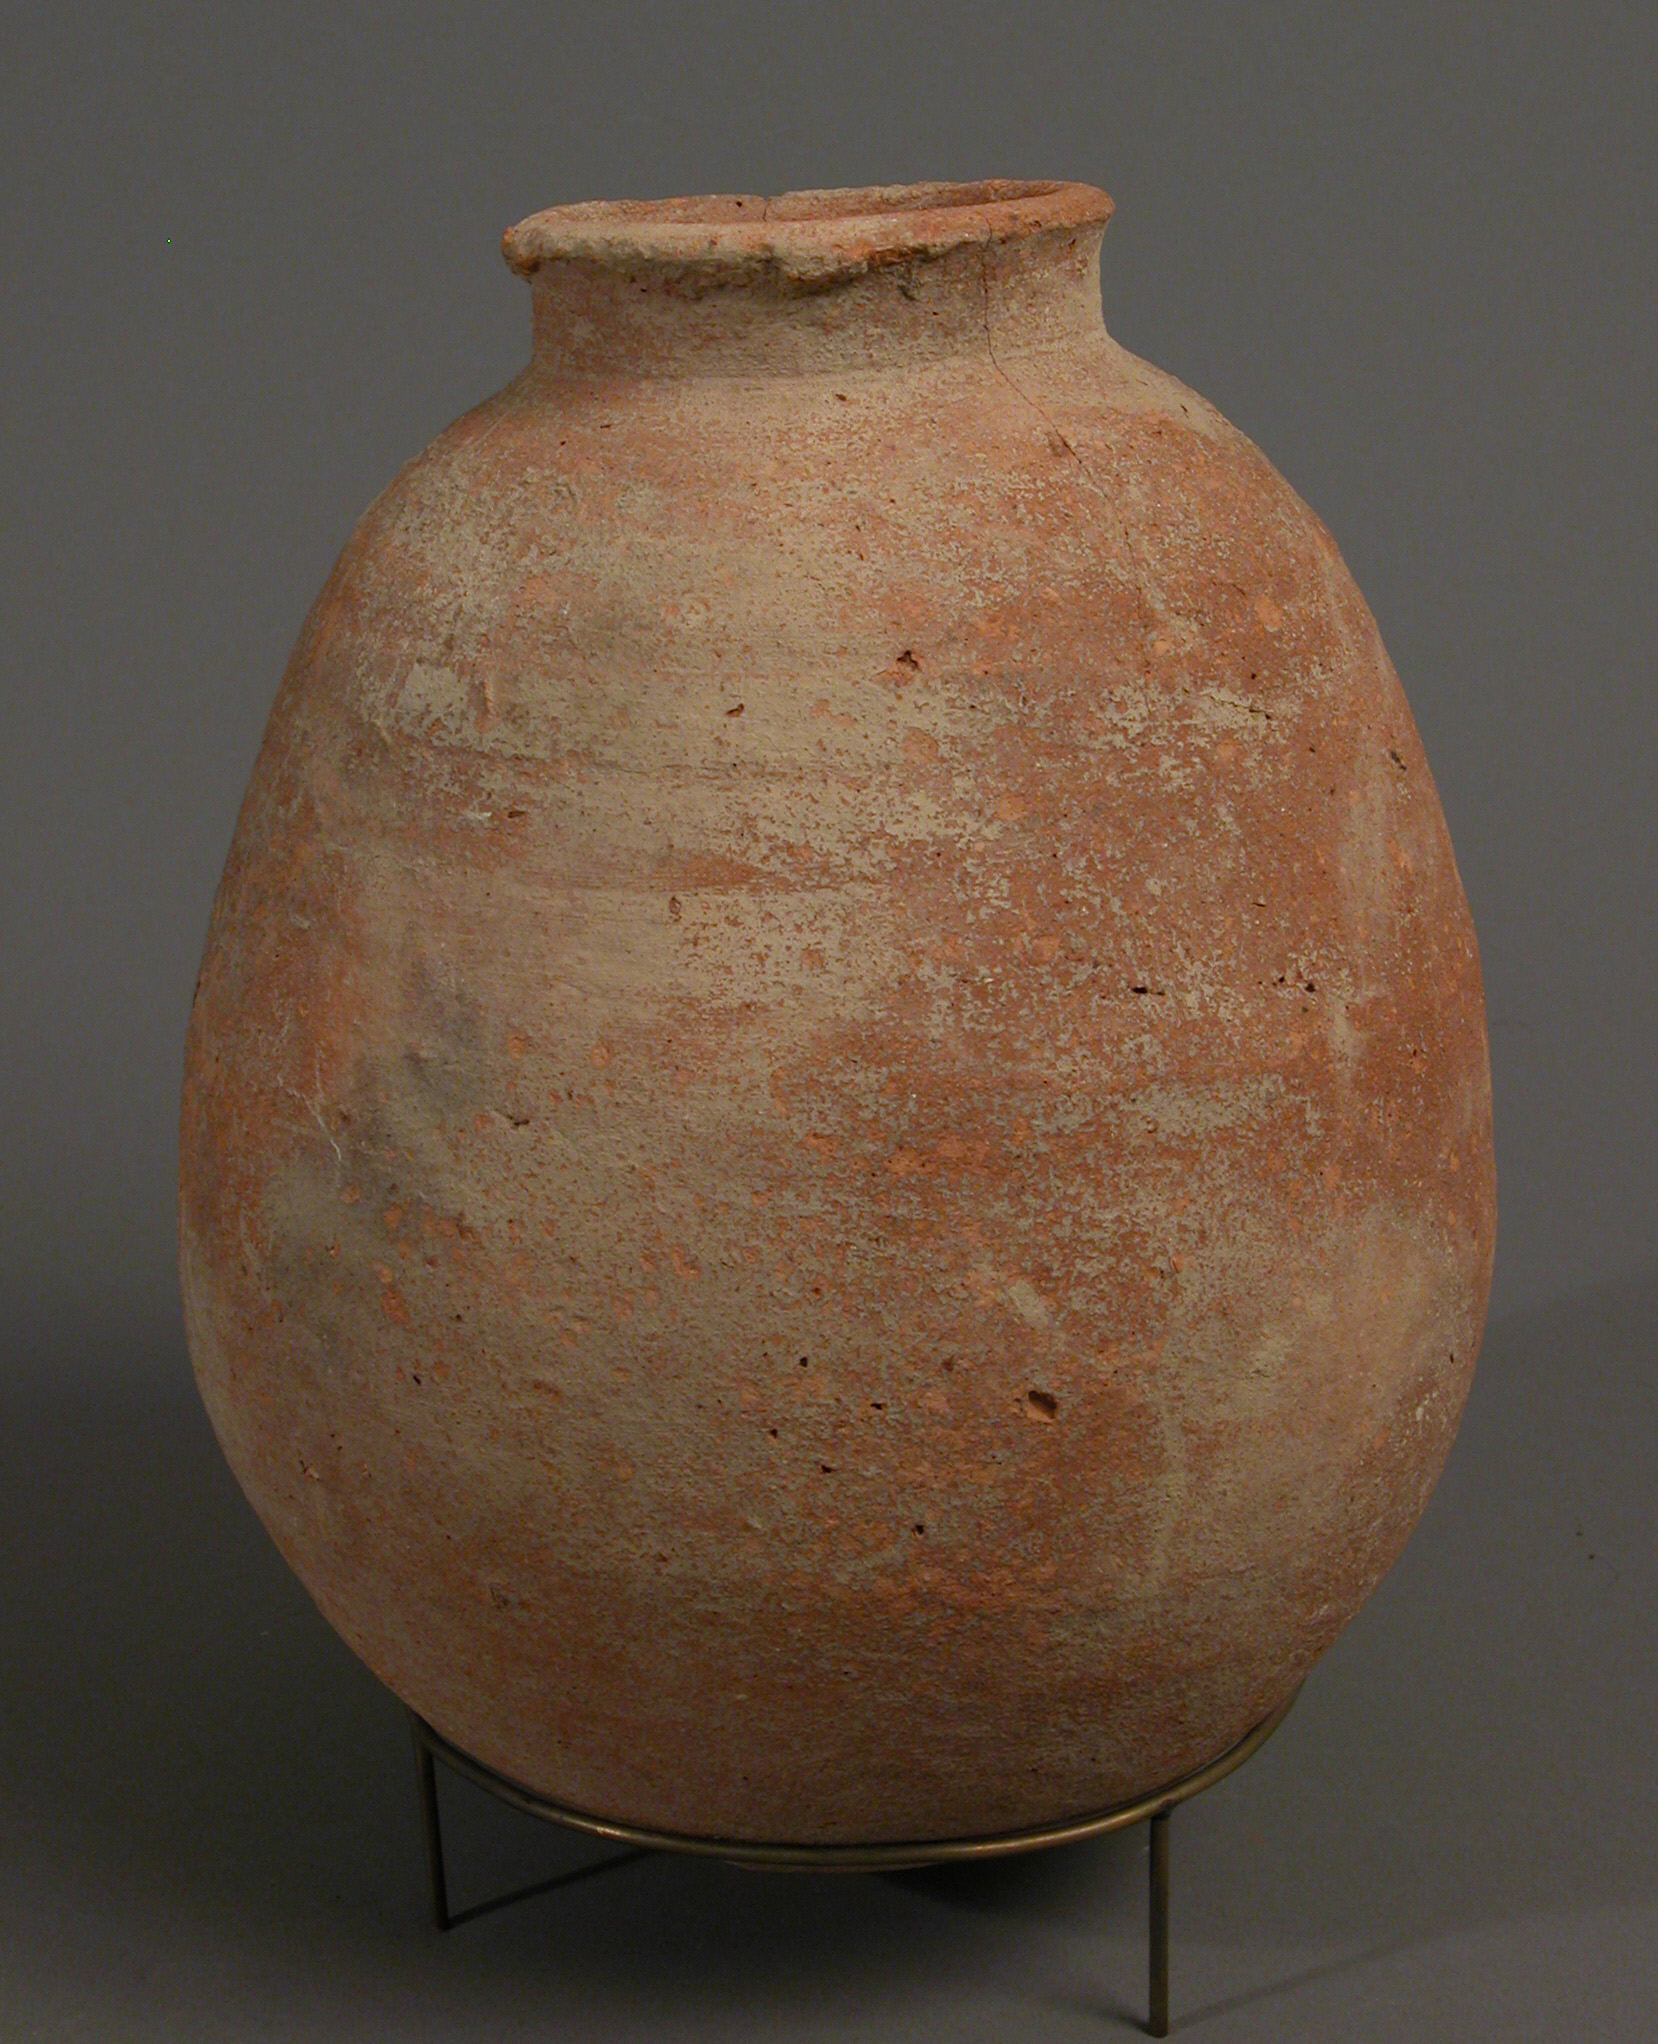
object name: pot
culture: coptic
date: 301-700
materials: earthenware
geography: egypt